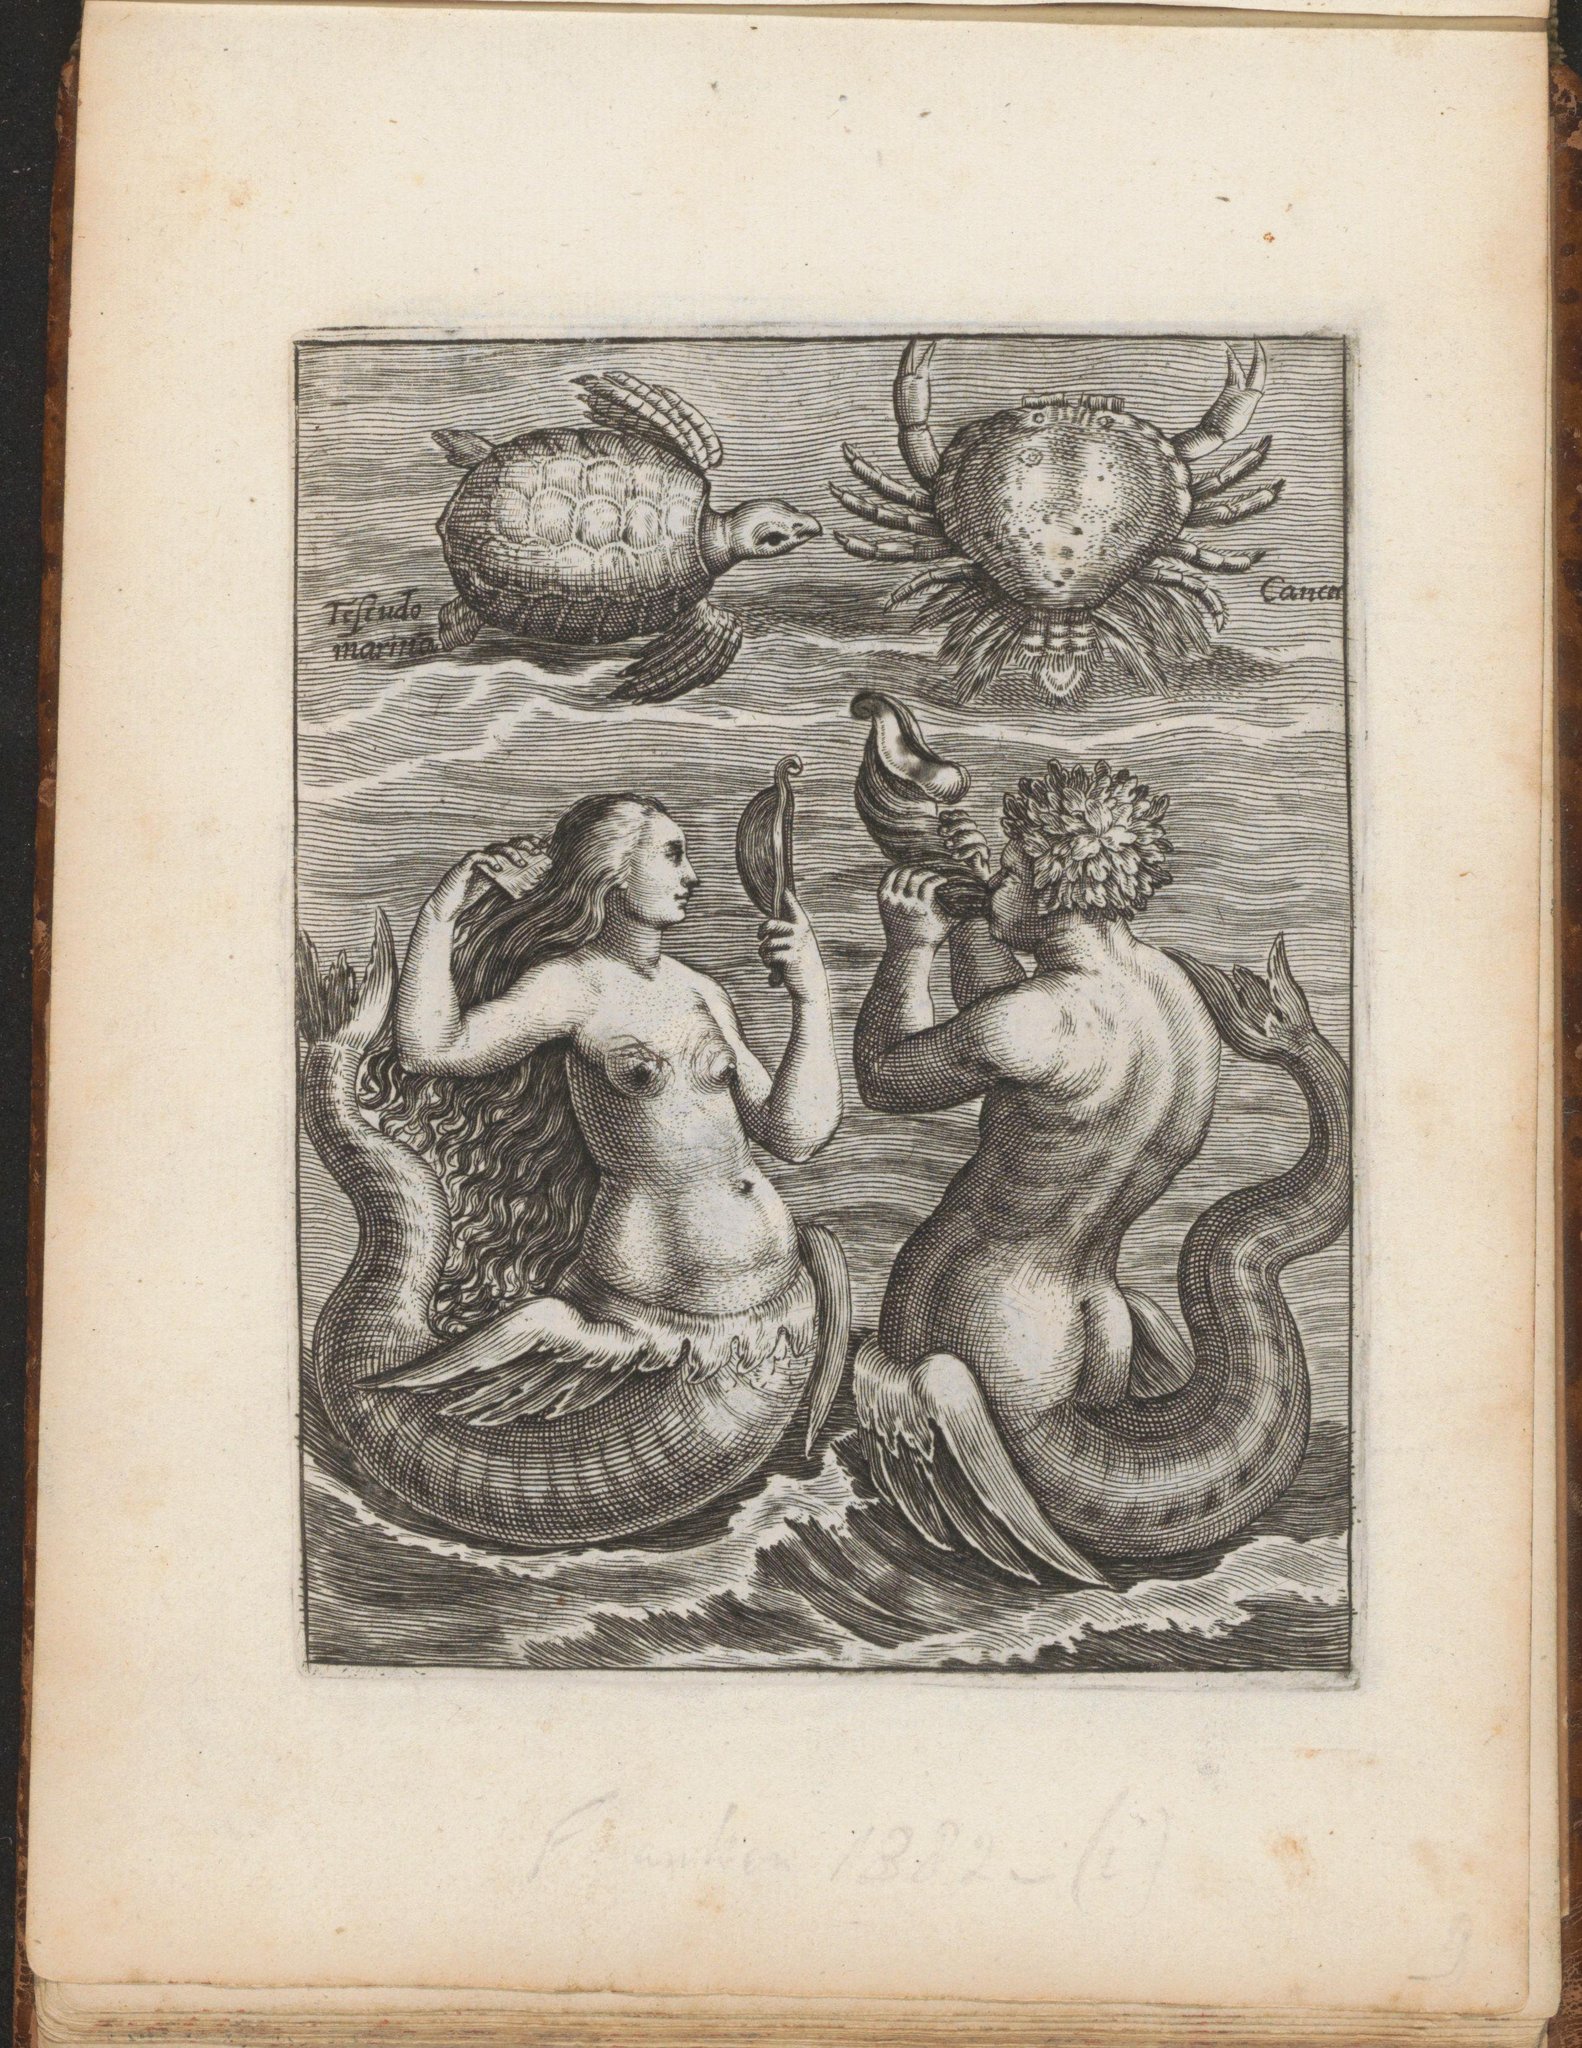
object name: album leaf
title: Schildpad, krab, zeemeermin en zeemeerman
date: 1635-1660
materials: paper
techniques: engraving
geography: utrecht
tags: tortoises, turtles, merman, merman - aa - mermaid, siren, crustaceans: crab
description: Een schildpad, een krab, een zeemeermin met kam en spiegel en een zeemeerman die op een schelp blaast. Deze prent maakt deel uit van een album.